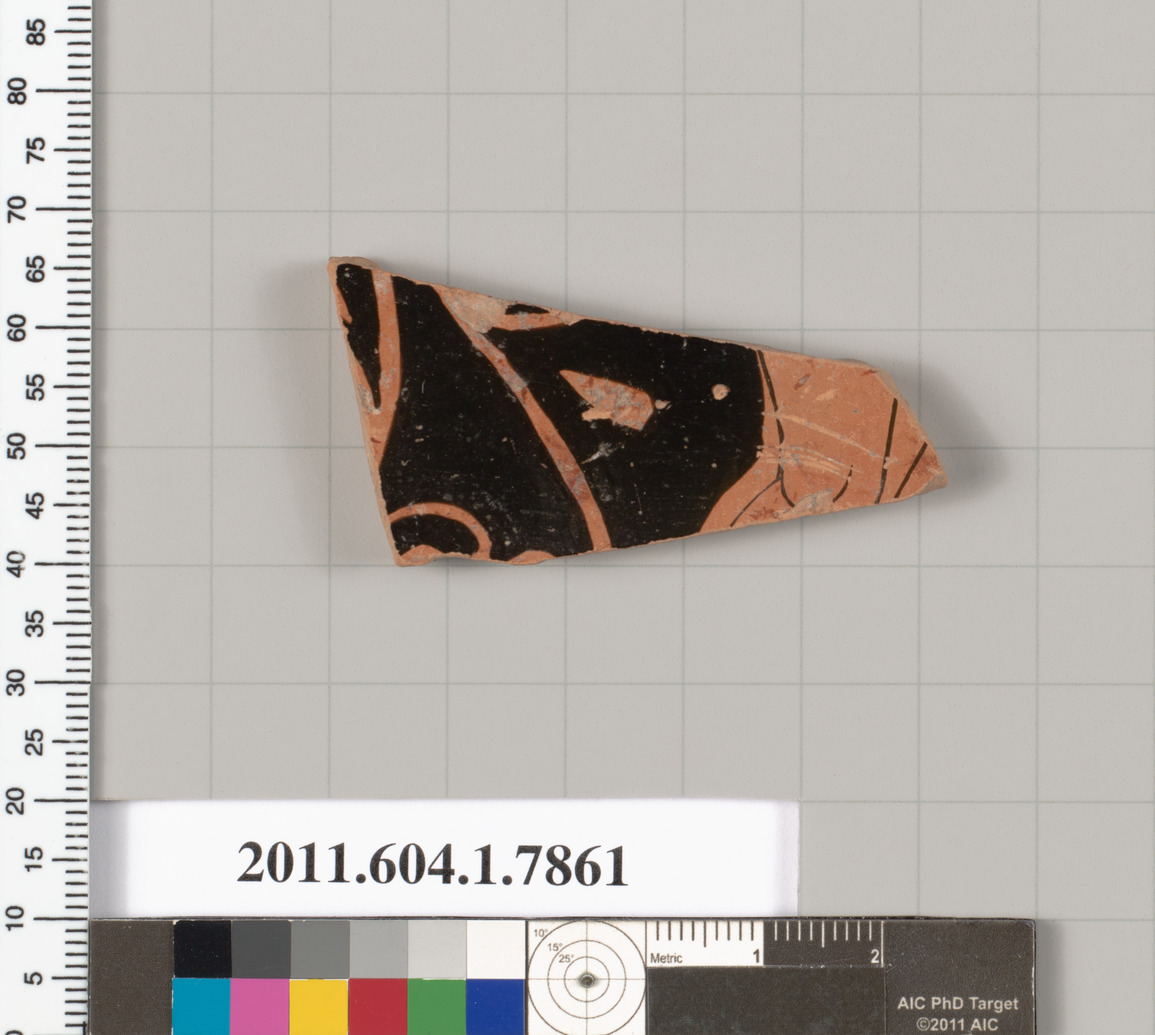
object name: kylix fragment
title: Terracotta fragment of a kylix (drinking cup)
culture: greek, attic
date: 440-420 BCE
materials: terracotta